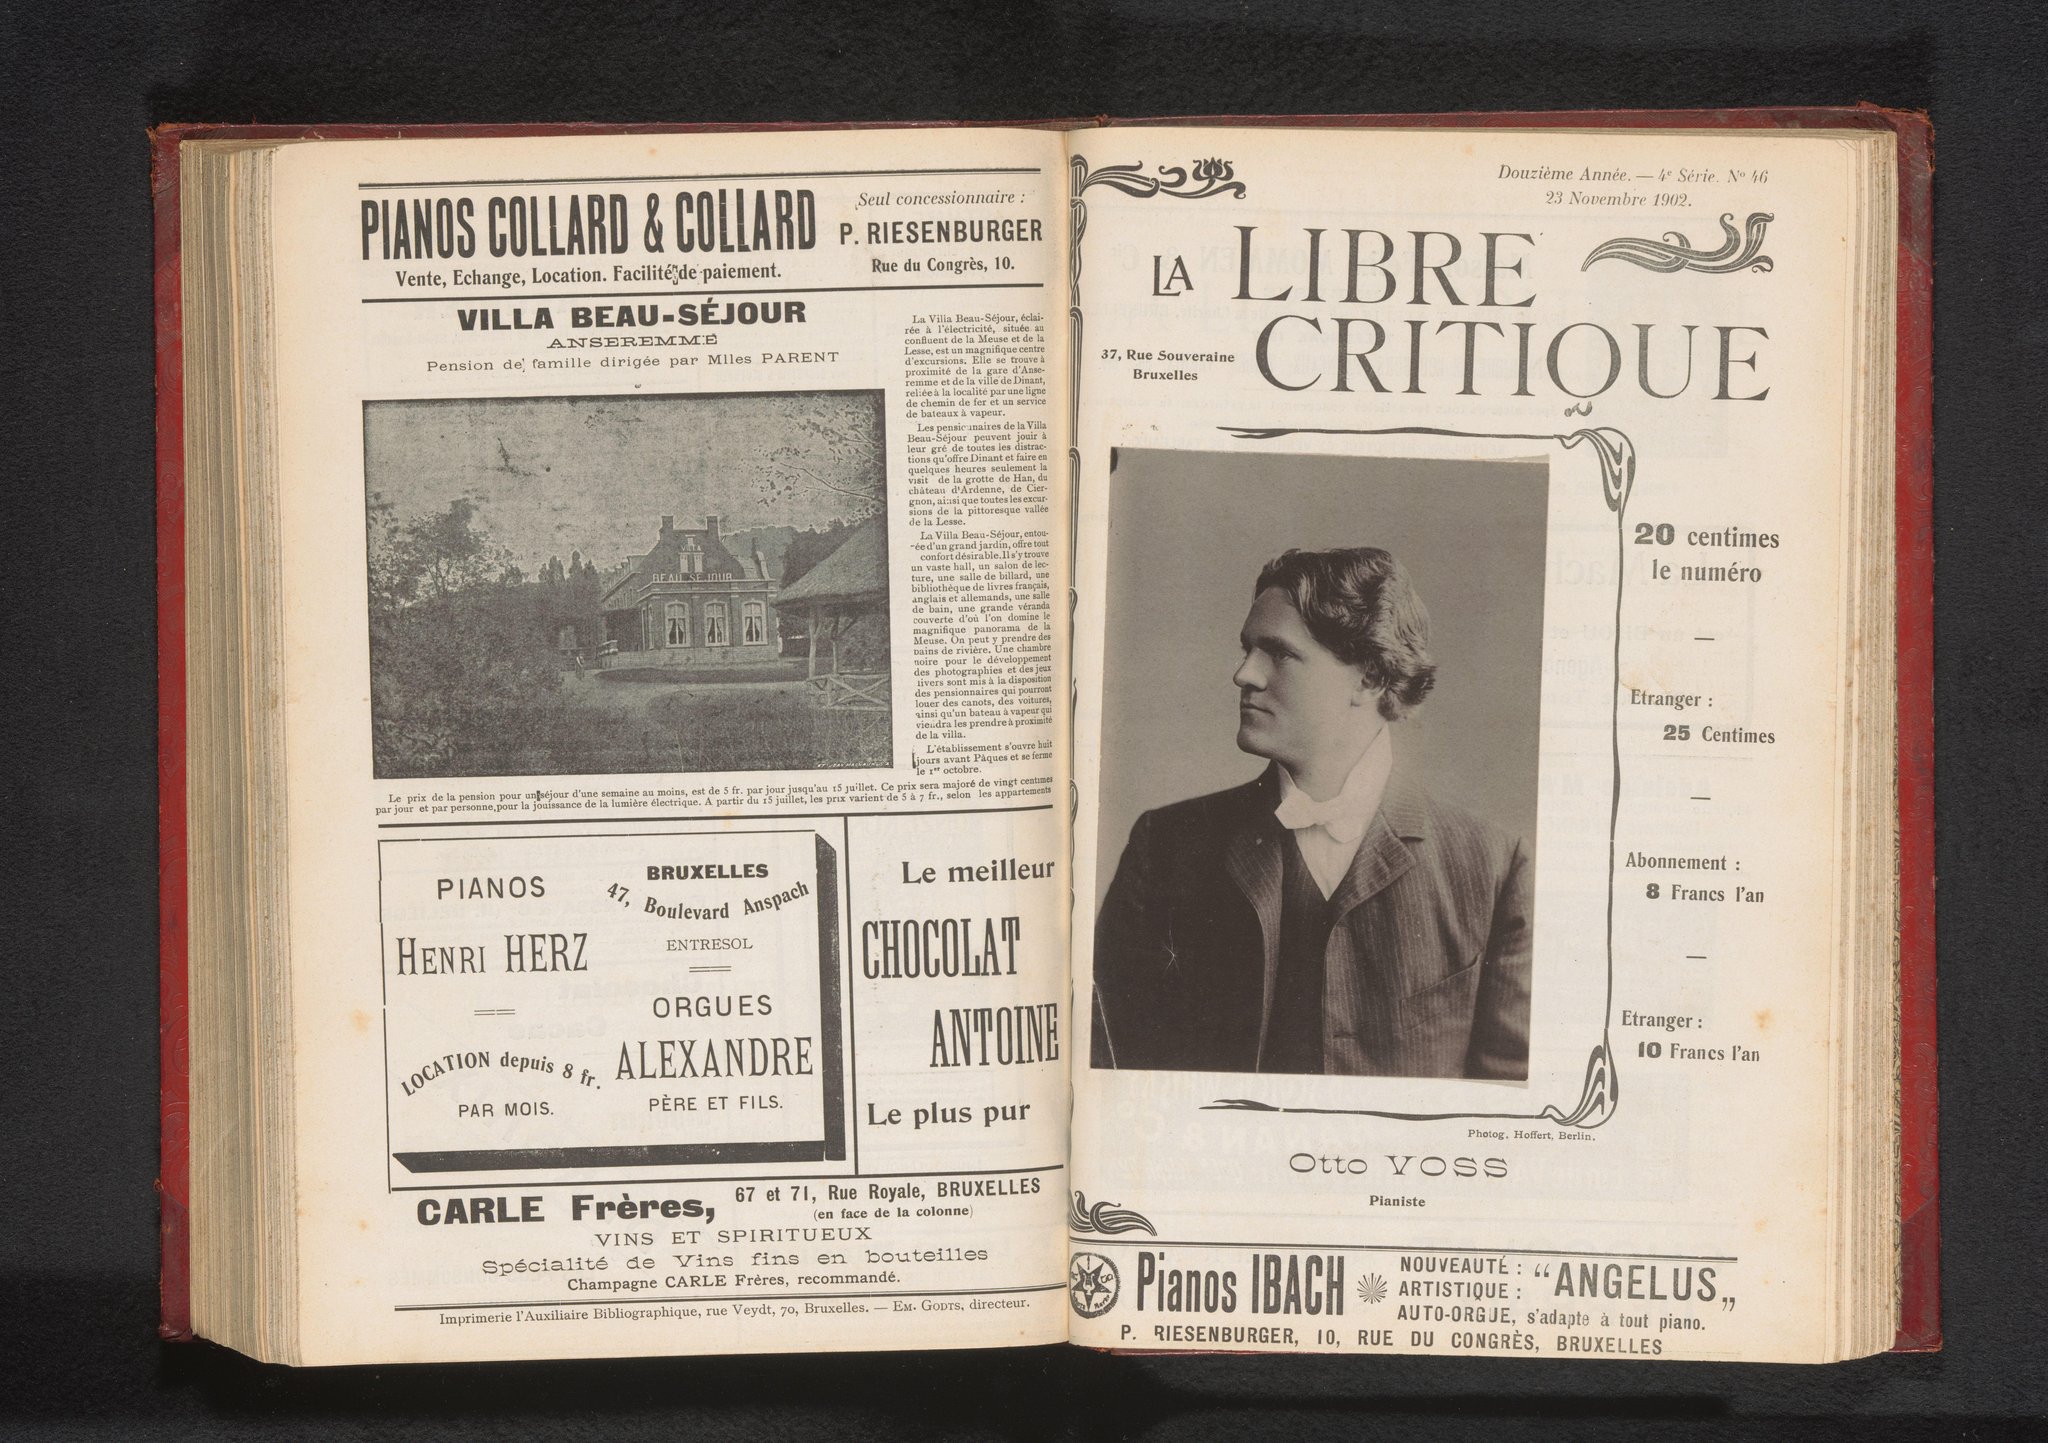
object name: photomechanical print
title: Otto Voss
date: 1897-1902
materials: paper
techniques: photograph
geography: berlin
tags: grand piano, portrait of a musician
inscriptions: inscription: ‘Pianiste’